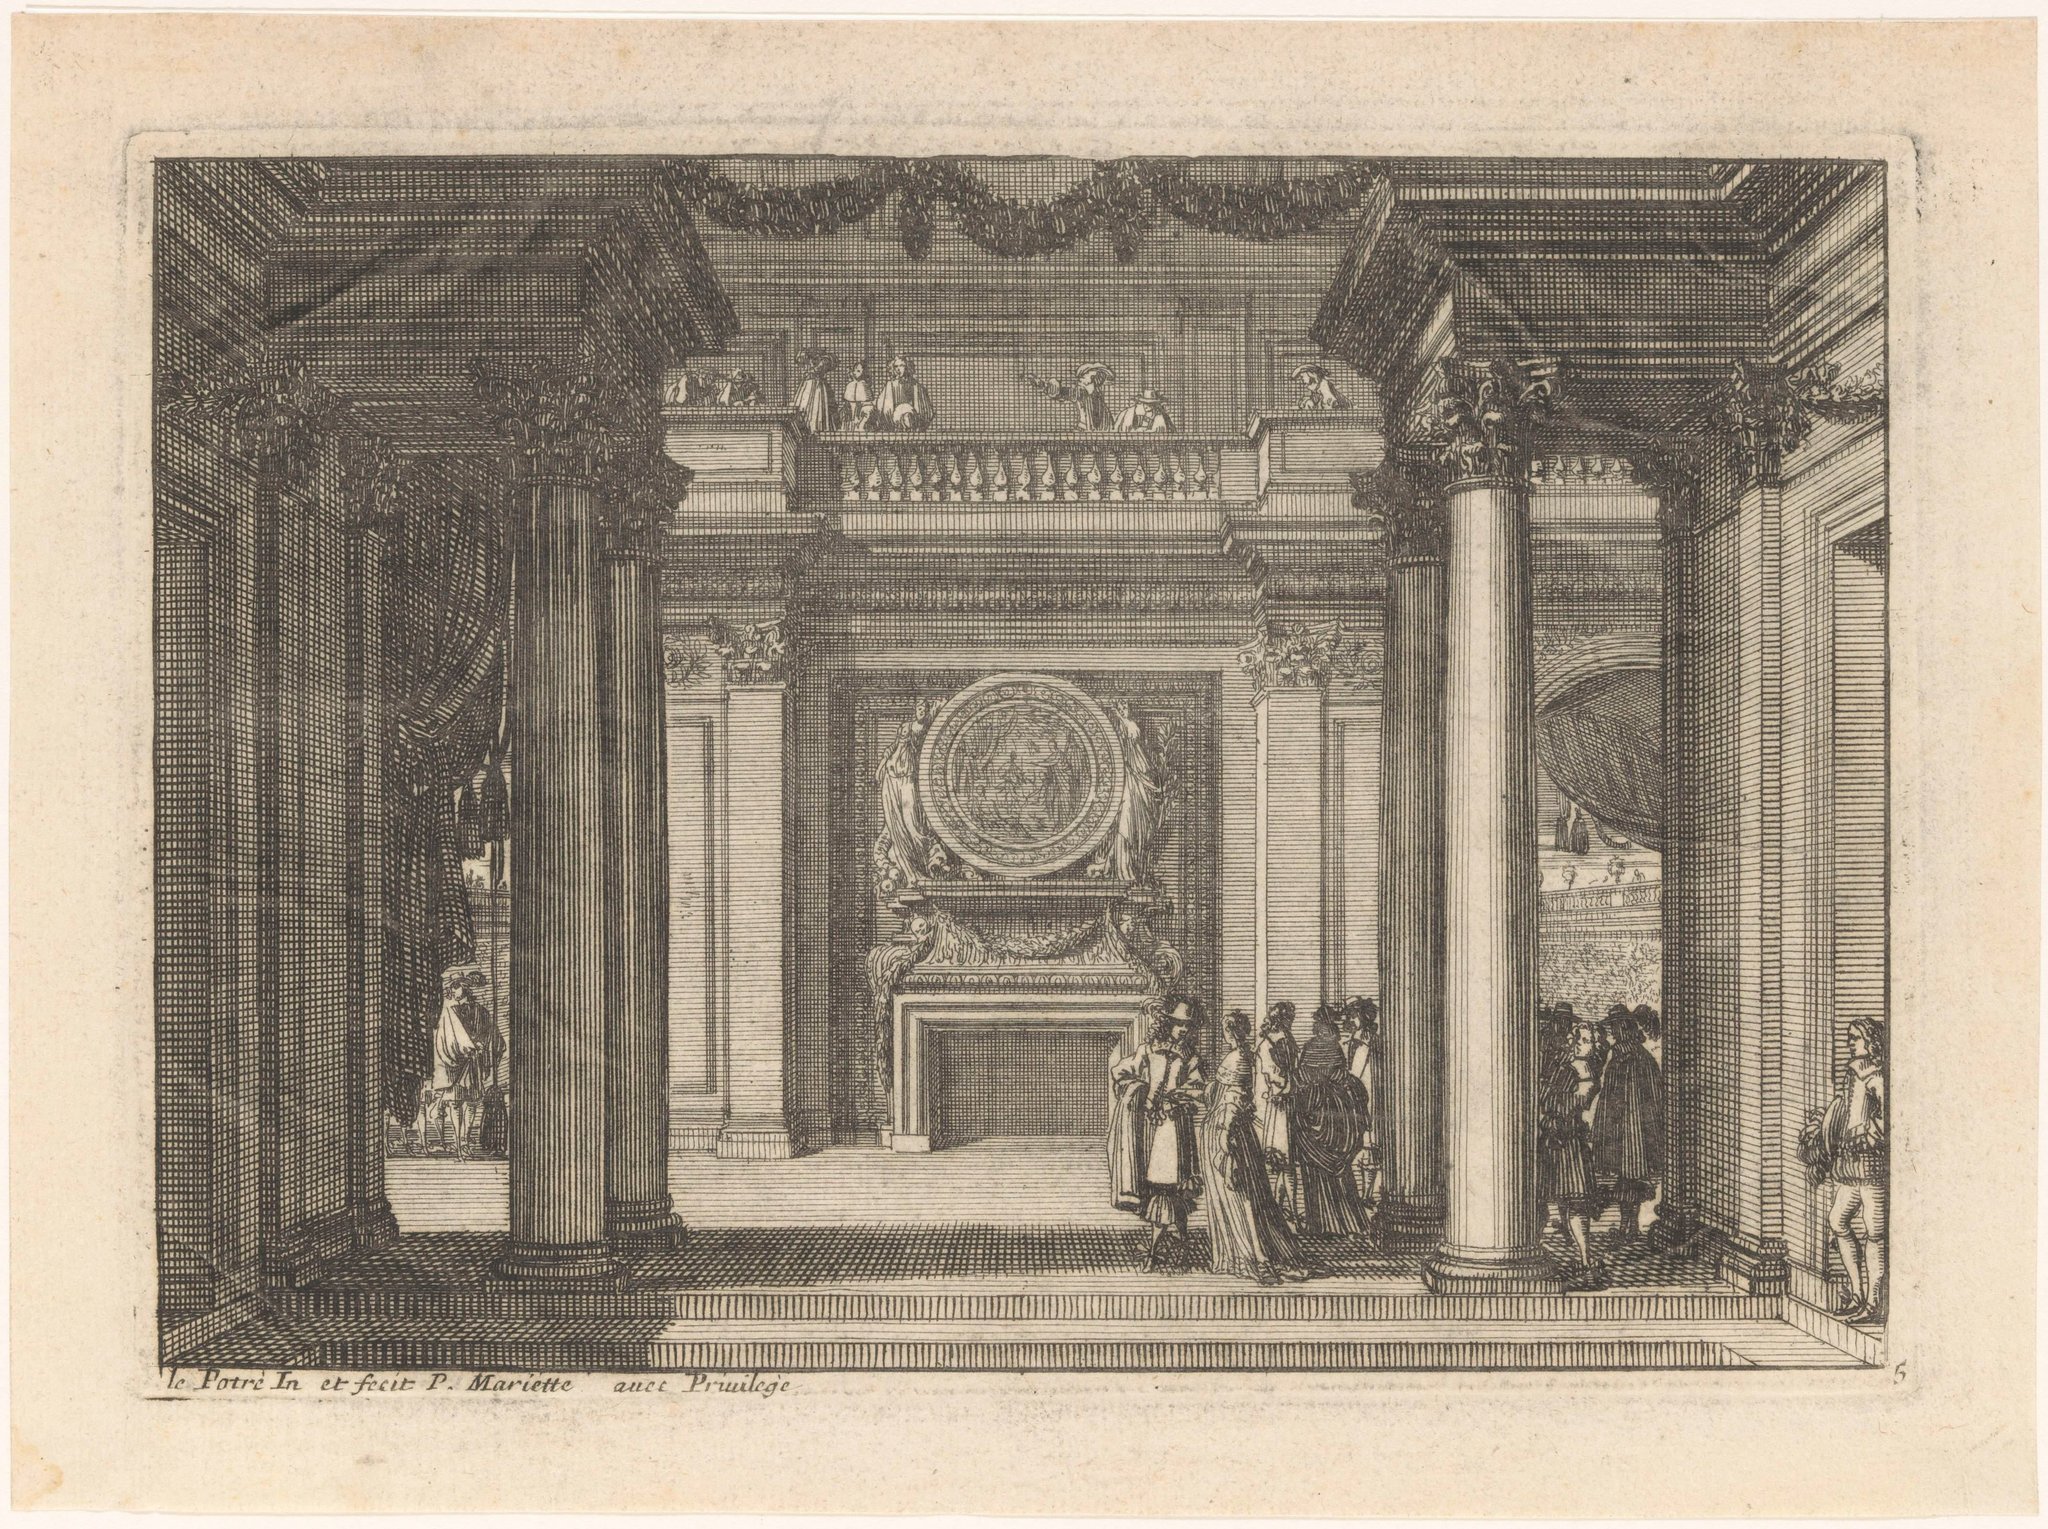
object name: ornament print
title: Schouw in voorkamer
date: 1665-1716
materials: paper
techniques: etching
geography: paris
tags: open hearth, fire-place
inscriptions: collector's mark: Lugt 2228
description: Een schouw met rond medaillon tegen de muur van een voorkamer met daarboven een balustrade. Rechts vooraan staat een groep mensen bij twee zuilen.